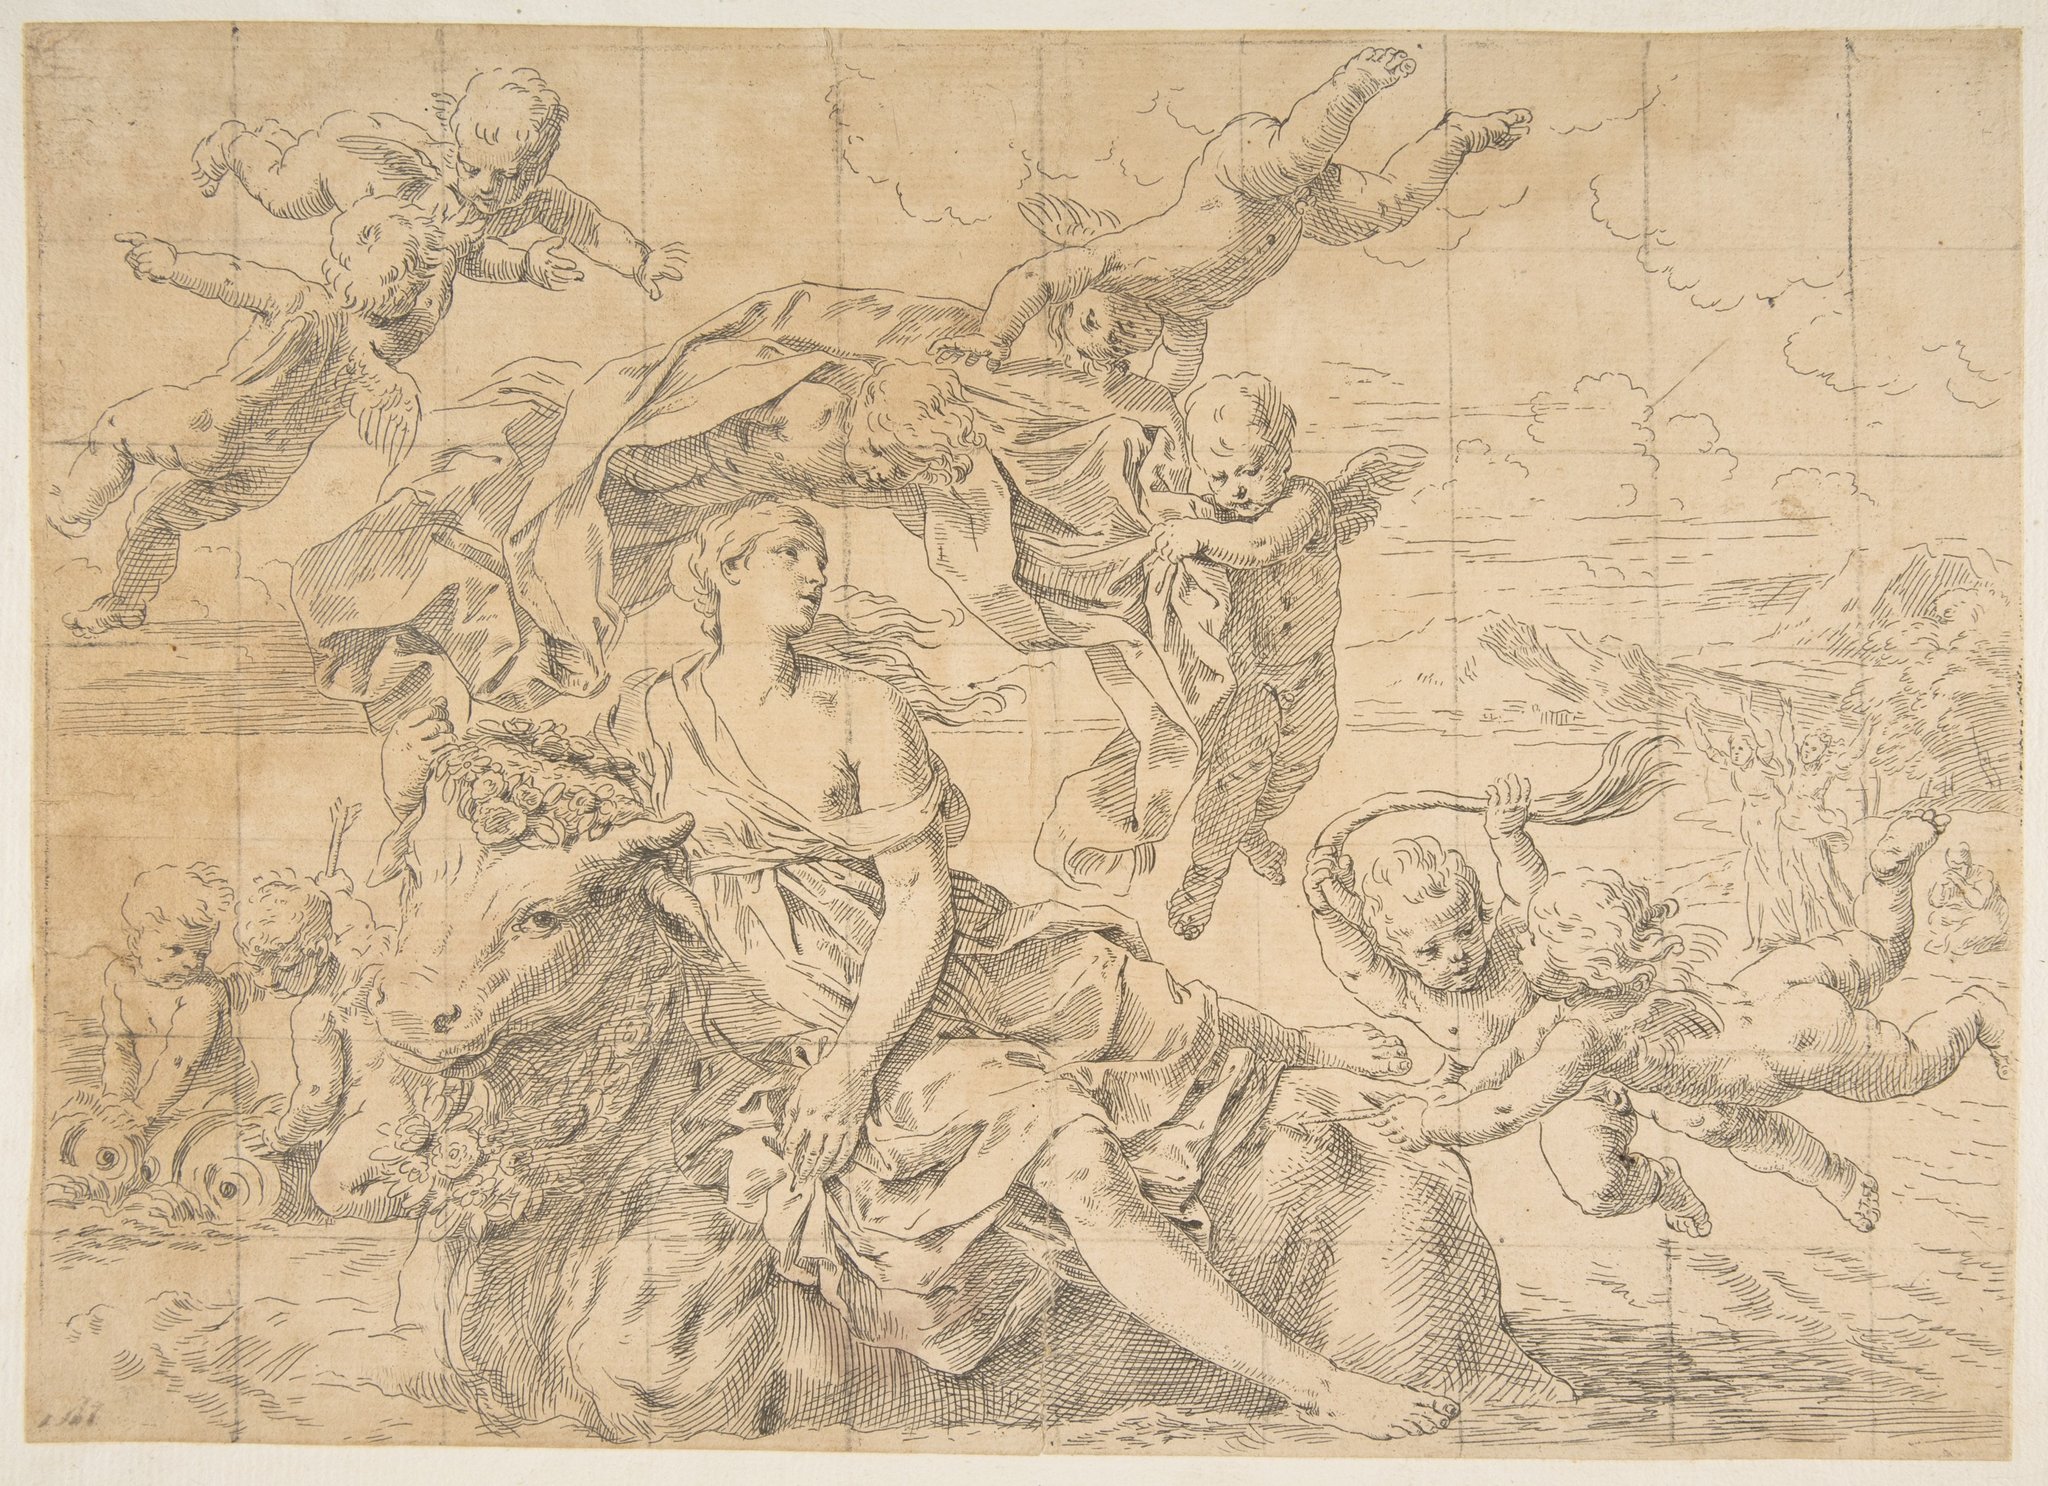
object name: print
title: Rape of Europa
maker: simone cantarini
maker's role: artist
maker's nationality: italian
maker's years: 1612-1648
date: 1636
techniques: drypoint, etching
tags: animals,europa